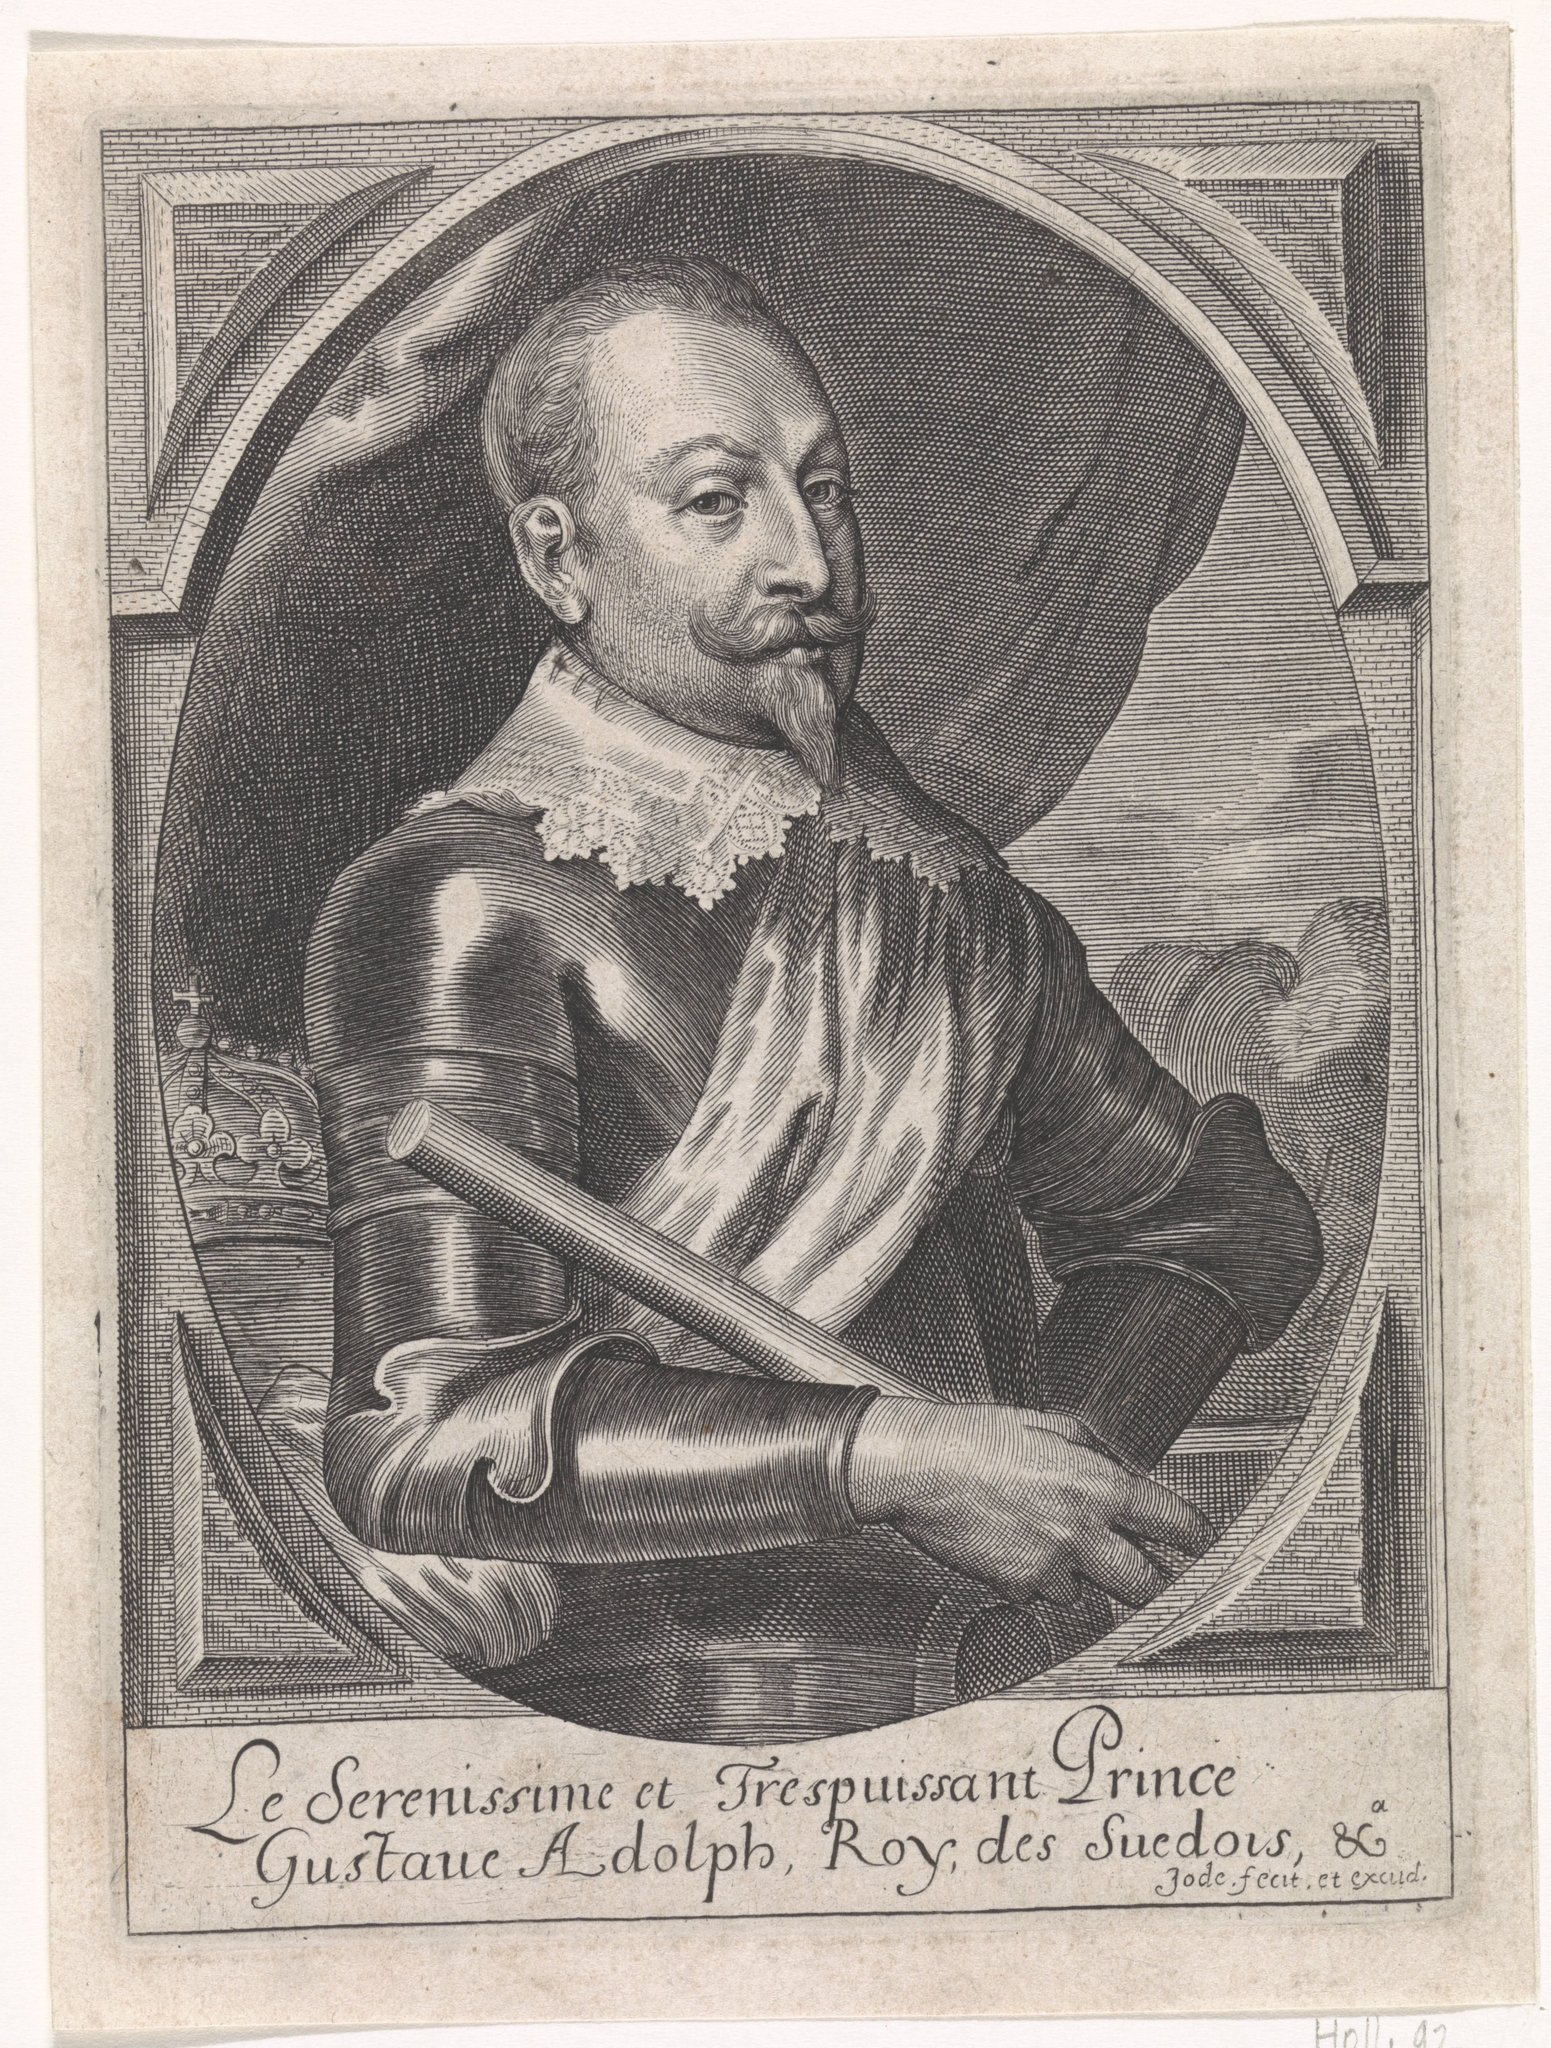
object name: print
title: Theatrum pontificum, imperatorum, regum, ducum, principum, etc.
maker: pieter de jode (ii)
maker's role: draughtsman, print maker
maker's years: 1606-1674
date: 1628-1670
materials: paper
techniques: engraving, etching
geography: antwerp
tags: crown (symbol of sovereignty), baton of general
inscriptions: collector's mark: Lugt 240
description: Portret van Gustaaf II Adolf, ten halven lijve. In zijn rechterhand houdt hij een commandostaf. Op de achtergrond een kroon. Het portret is gevat in een ovale omlijsting met vierkant randwerk. In de marge een tweeregelig onderschrift in het Frans.